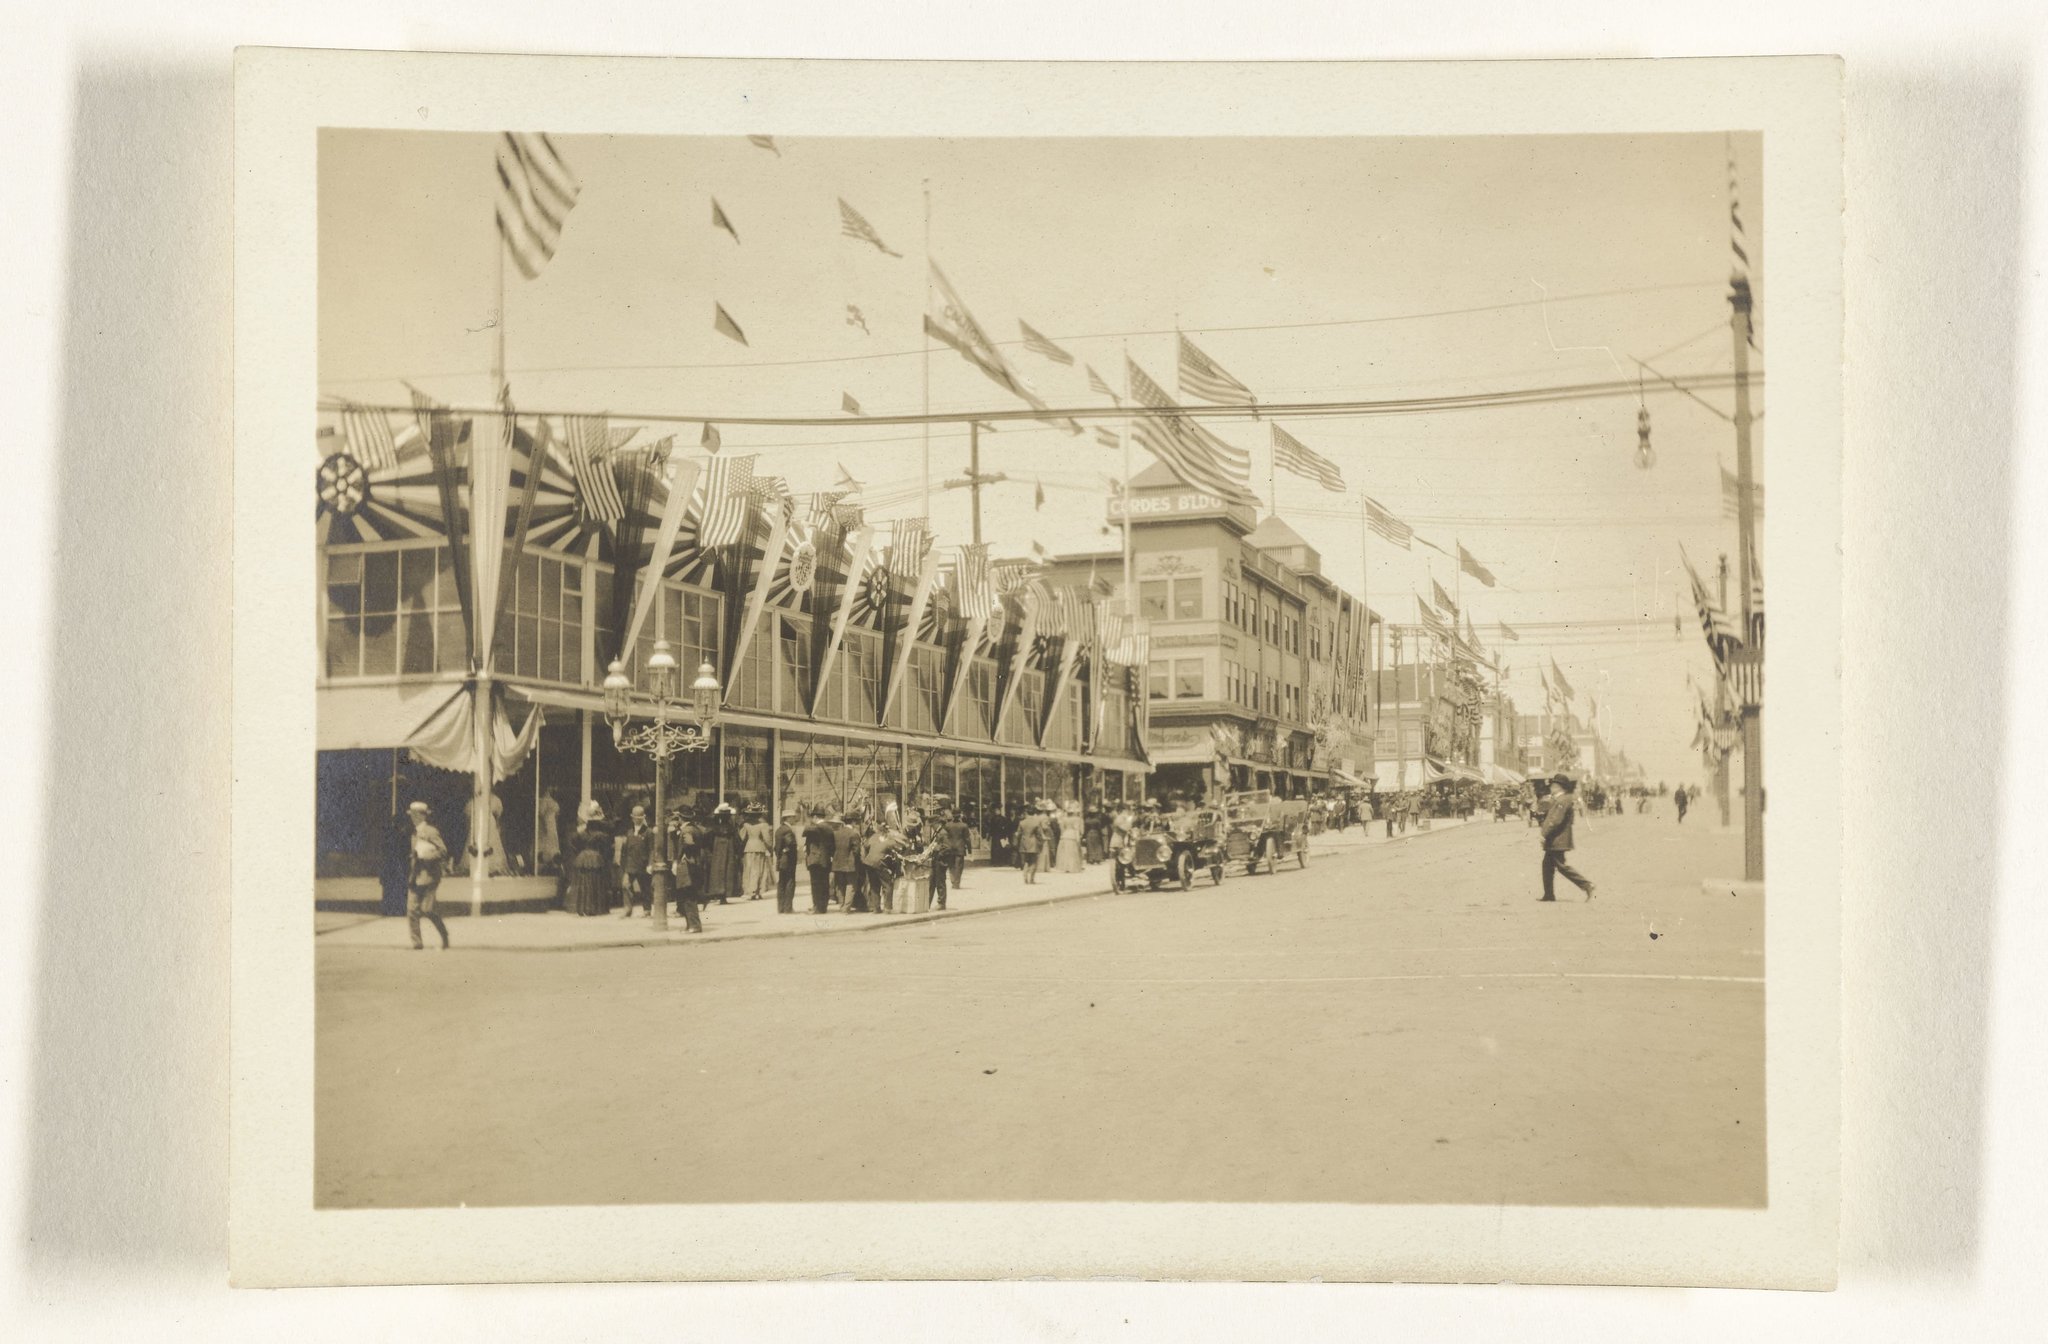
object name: photograph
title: Van Nes avenue in feast trim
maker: geldolph adriaan kessler (dolph)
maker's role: fotograaf, industrieel, voetballer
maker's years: 1884-1945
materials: cardboard, photographic support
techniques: gelatin silver print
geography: san francisco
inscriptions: title: ‘Van Nes avenue in feast trim’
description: Met vlaggen versierde Van Ness Avenue in San Francisco. Onderdeel van het fotoalbum van Dolph Kessler met opnamen die hij maakte tijdens zijn verblijf in Engeland en op een wereldreis die hij als secretaris van Henri Deterding (directeur Koninklijke Olie) ondernam naar Nederlands-Indië, Japan, China en de Verenigde Staten, tussen 1906 en 1908.